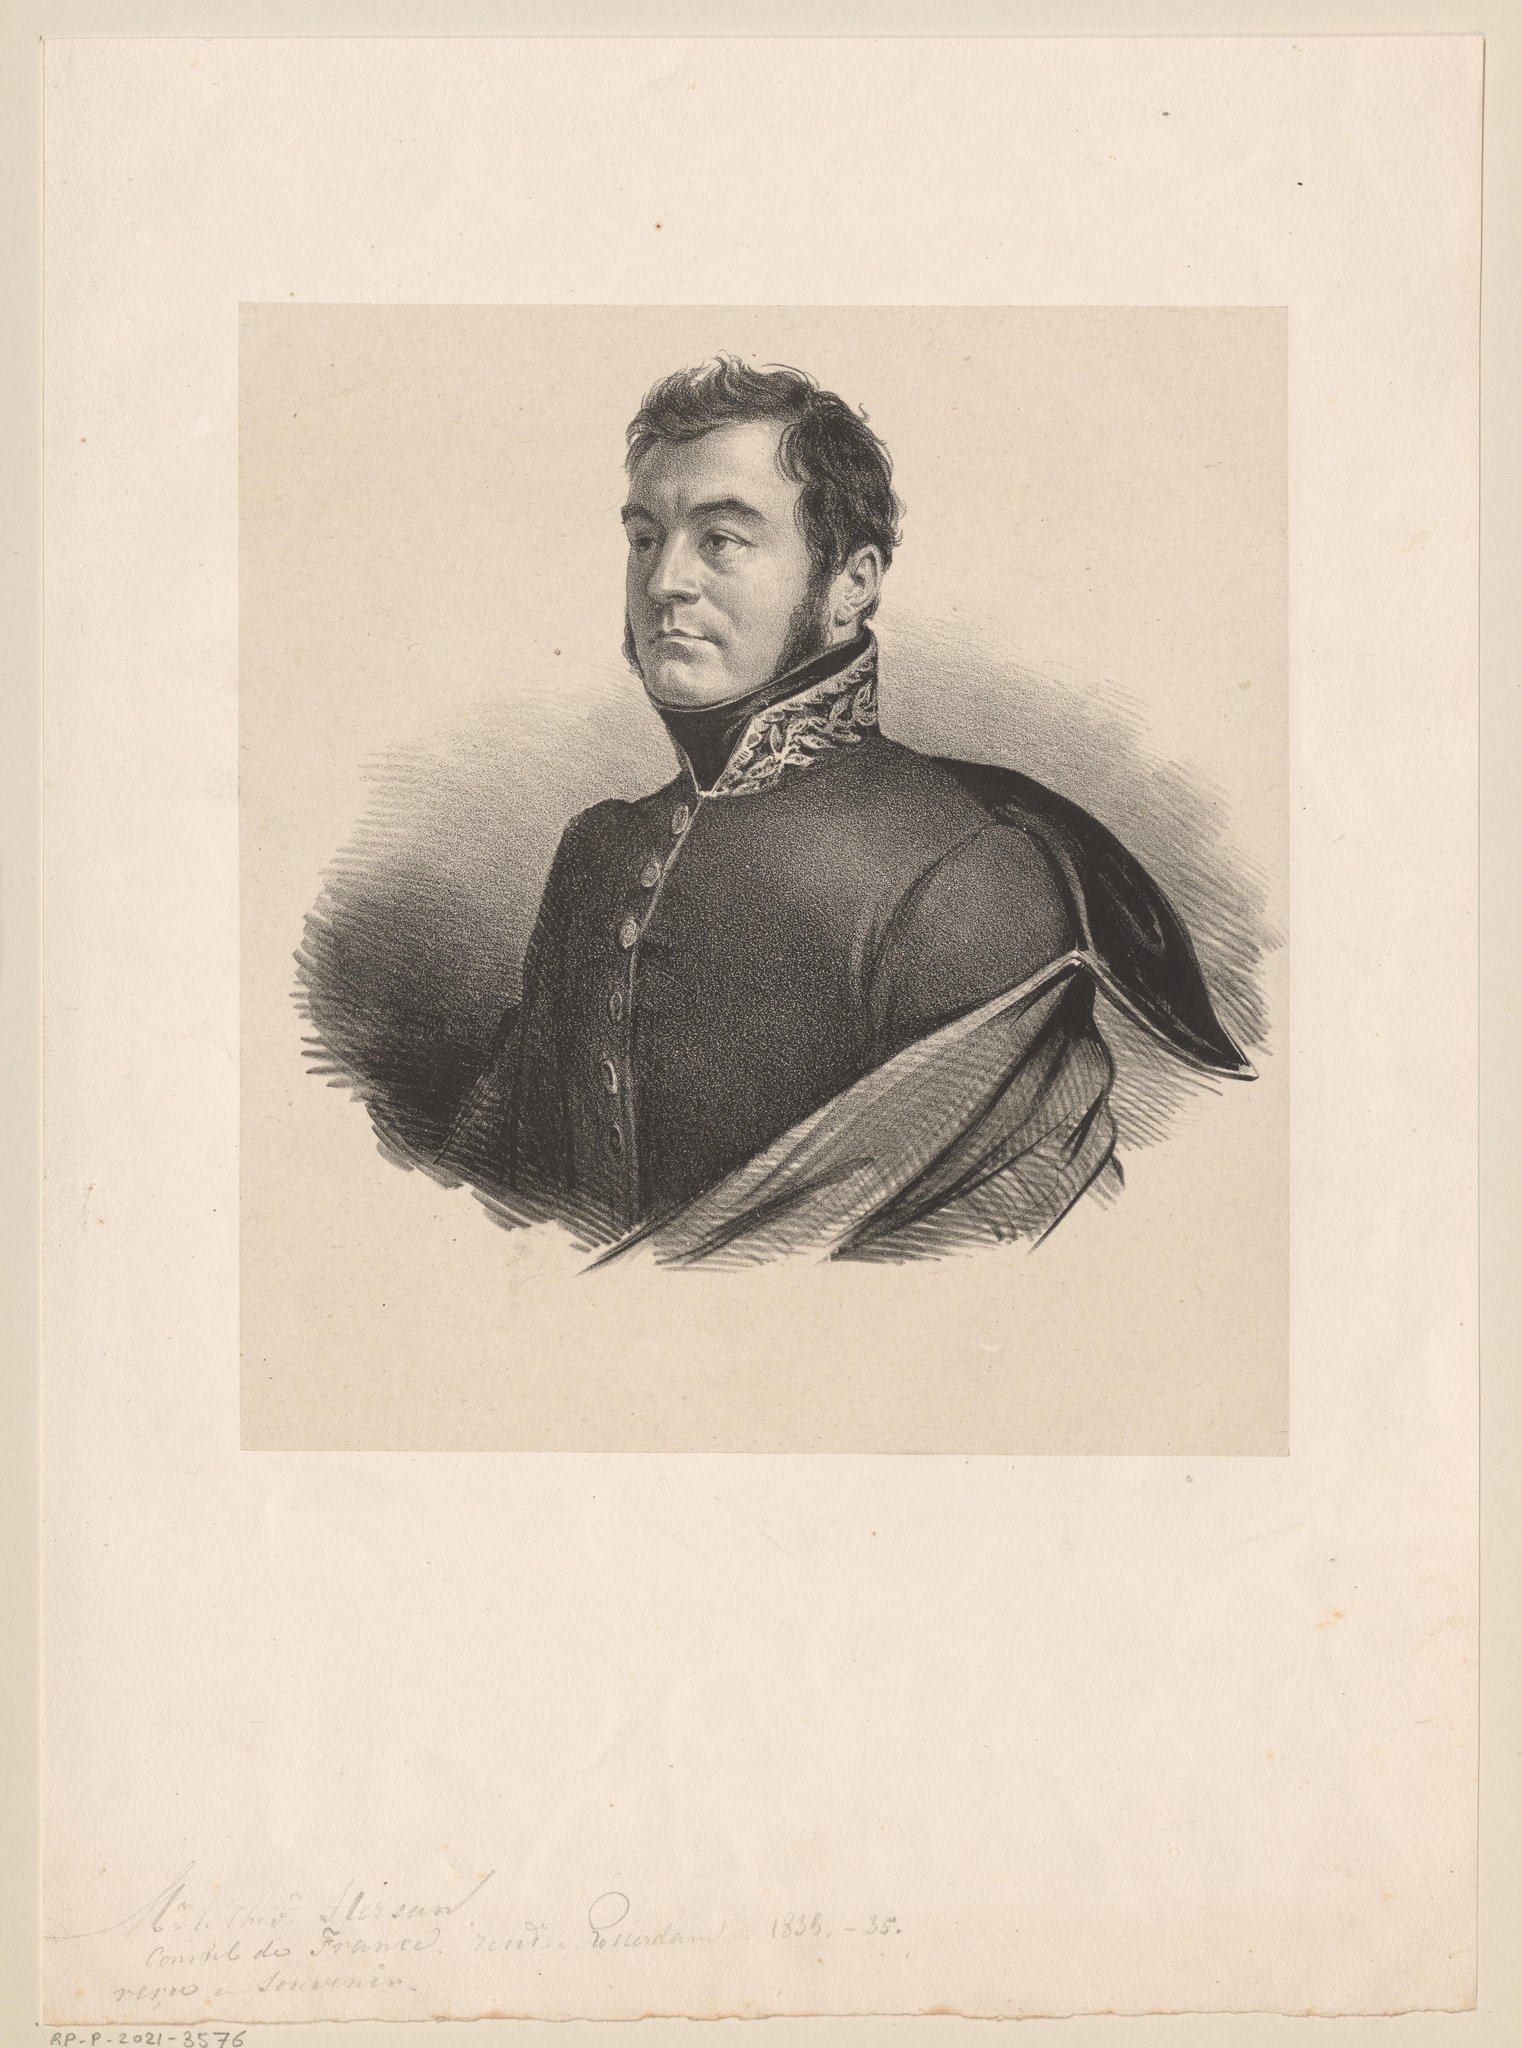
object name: print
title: Portret van Hersan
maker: Anonymous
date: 1830-1840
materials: paper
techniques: lithograph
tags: historical persons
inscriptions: inscription: ‘Mr de Chev[alier] Hersan/ consul de France [...] Rotterdam de 183[...] - 35./ ver[...] souvenir’